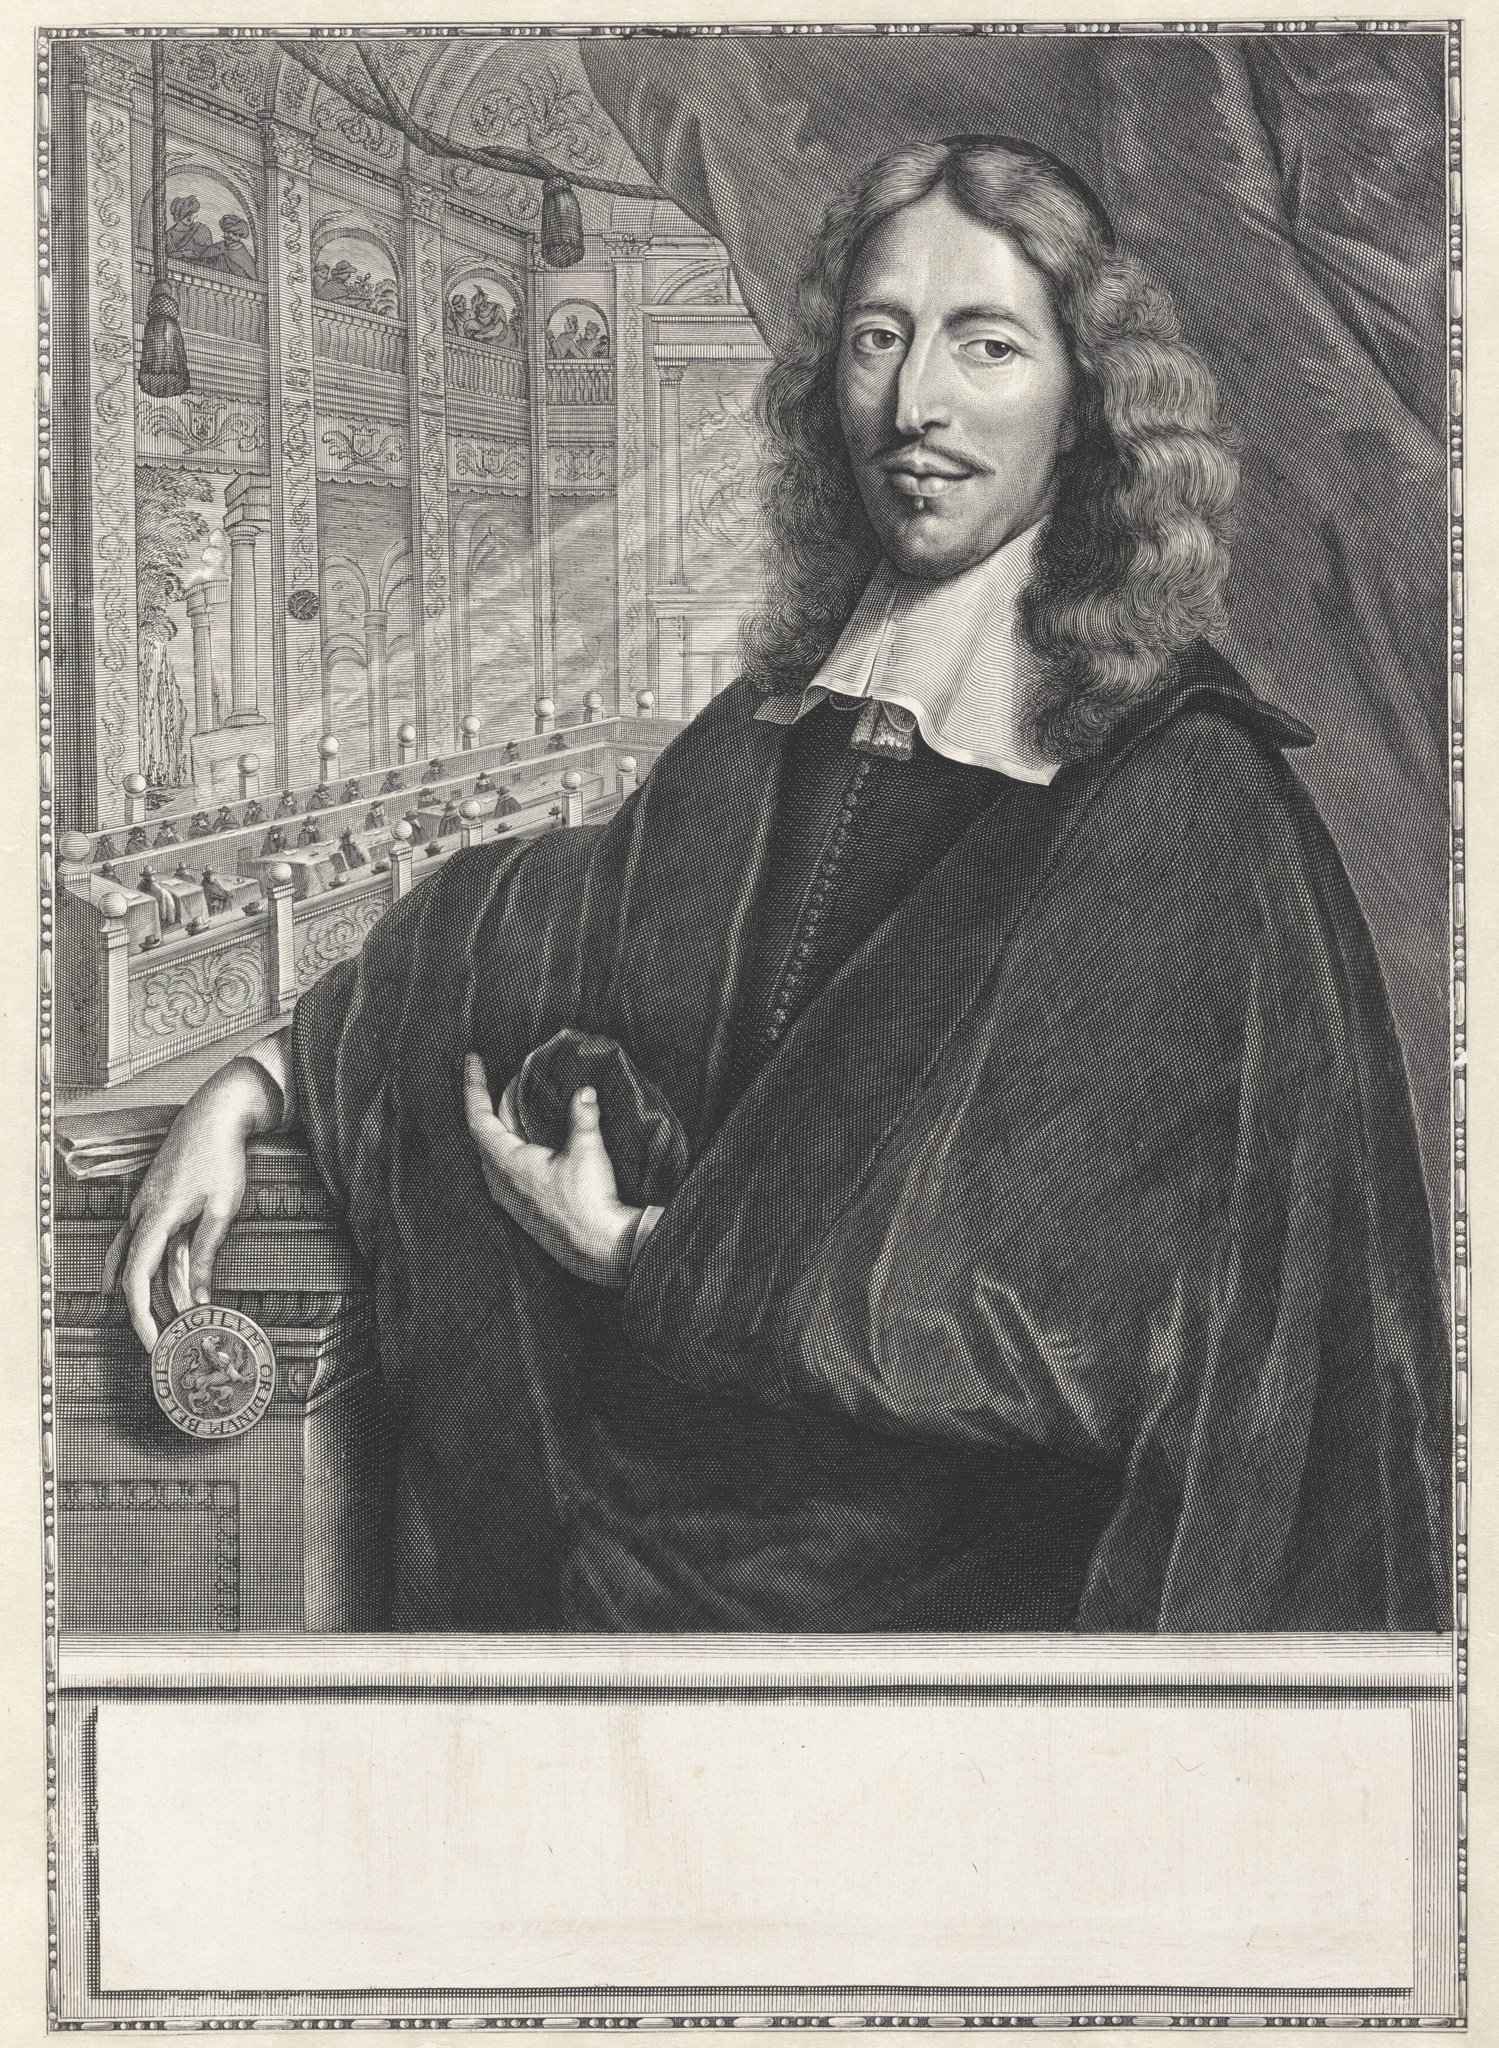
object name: print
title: Portret van Johan de Witt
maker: lambert visscher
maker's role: draughtsman, print maker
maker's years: 1640-1679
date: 1643-1690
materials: paper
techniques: engraving, etching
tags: the hague, politician, johan de witt, coat (+ men's clothes), seal, stamp, court session (court of justice)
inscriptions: collector's mark: Lugt 240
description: Portret van de advocaat Johan de Witt, raadpensionaris van het gewest Holland. Hij is gekleed in een mantel en staat voor een gordijn met daarachter een vergaderzaal. In zijn rechterhand heeft hij een zegel met de Nederlandse leeuw, symbool voor de Republiek.